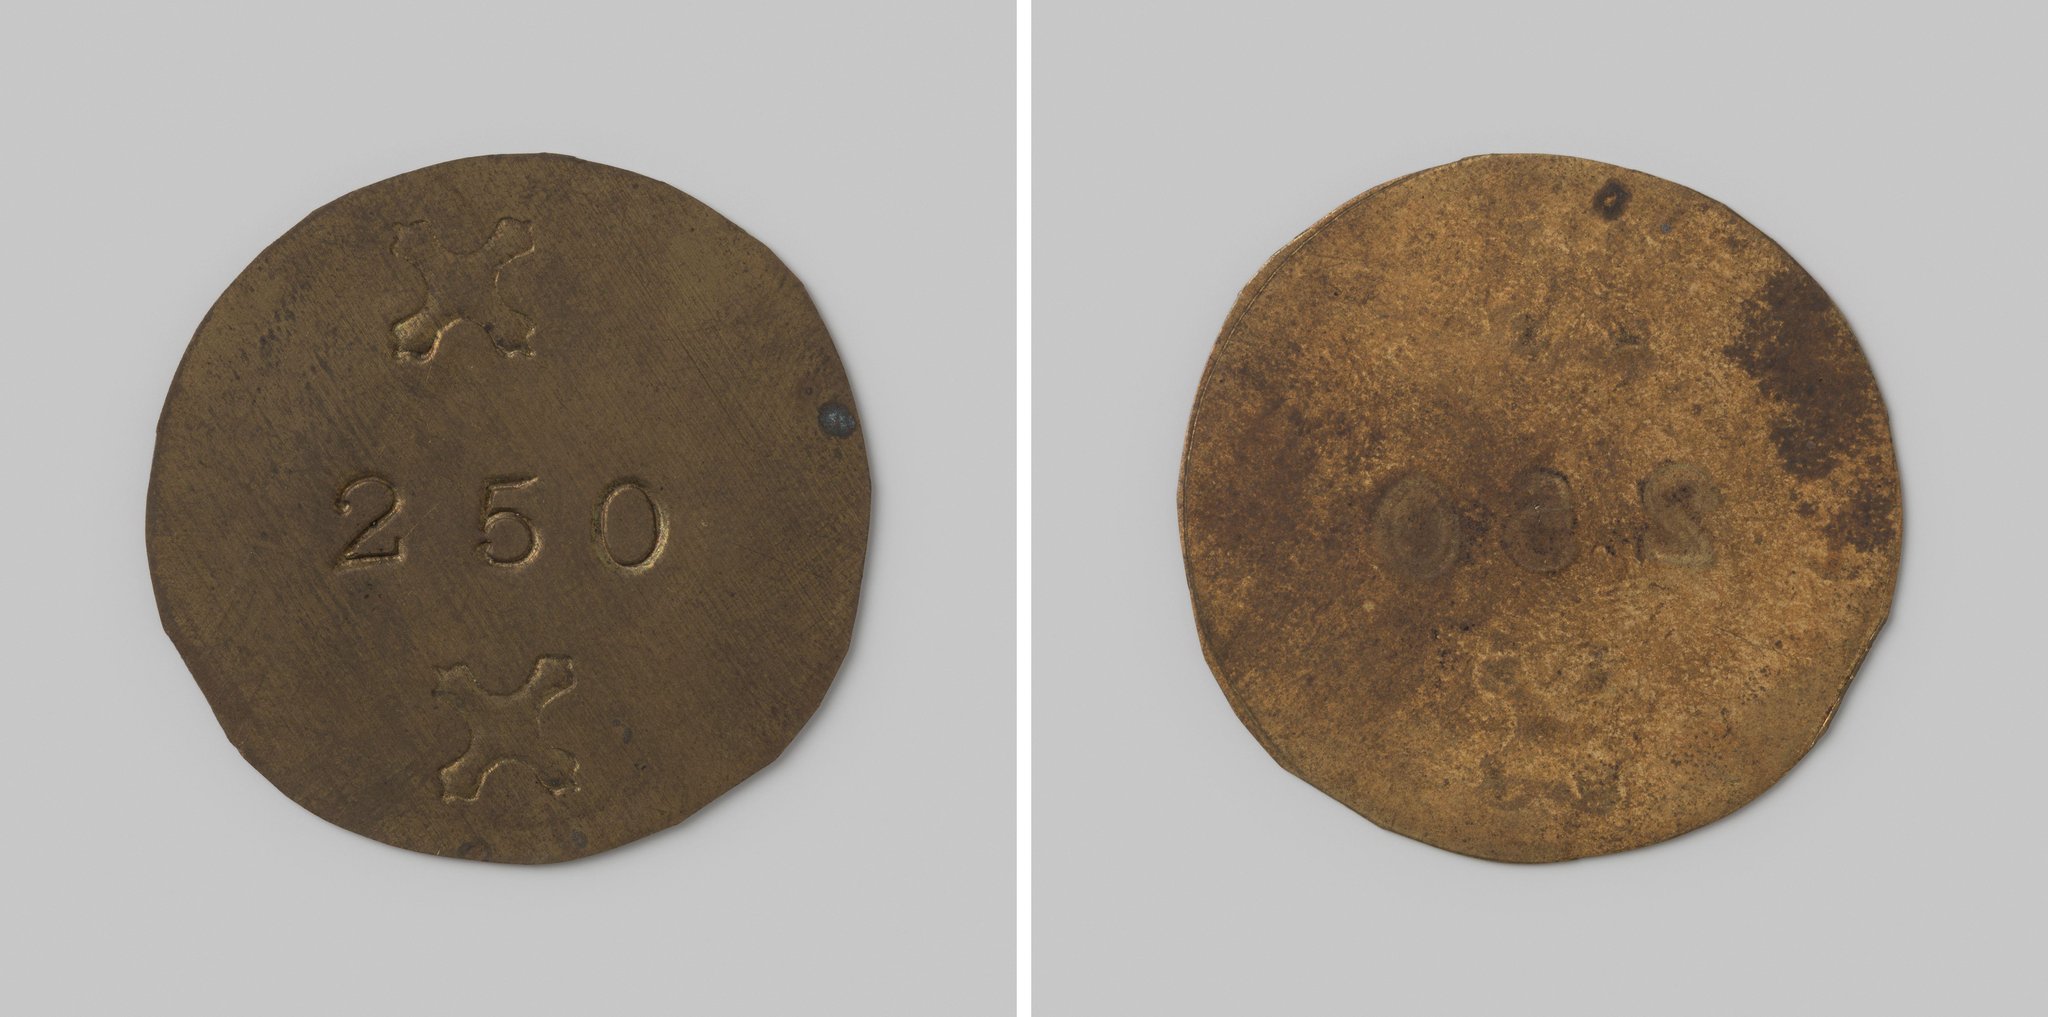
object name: twee en een halve gulden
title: Betaalpenning van tweeënhalve gulden van de Coöperatieve Winkelvereeniging De Volharding te Veenendaal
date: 1875-1900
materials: brass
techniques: printing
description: Rond messing plaatje met instempelingen (andreaskruis) / 250 / (andreaskruis)